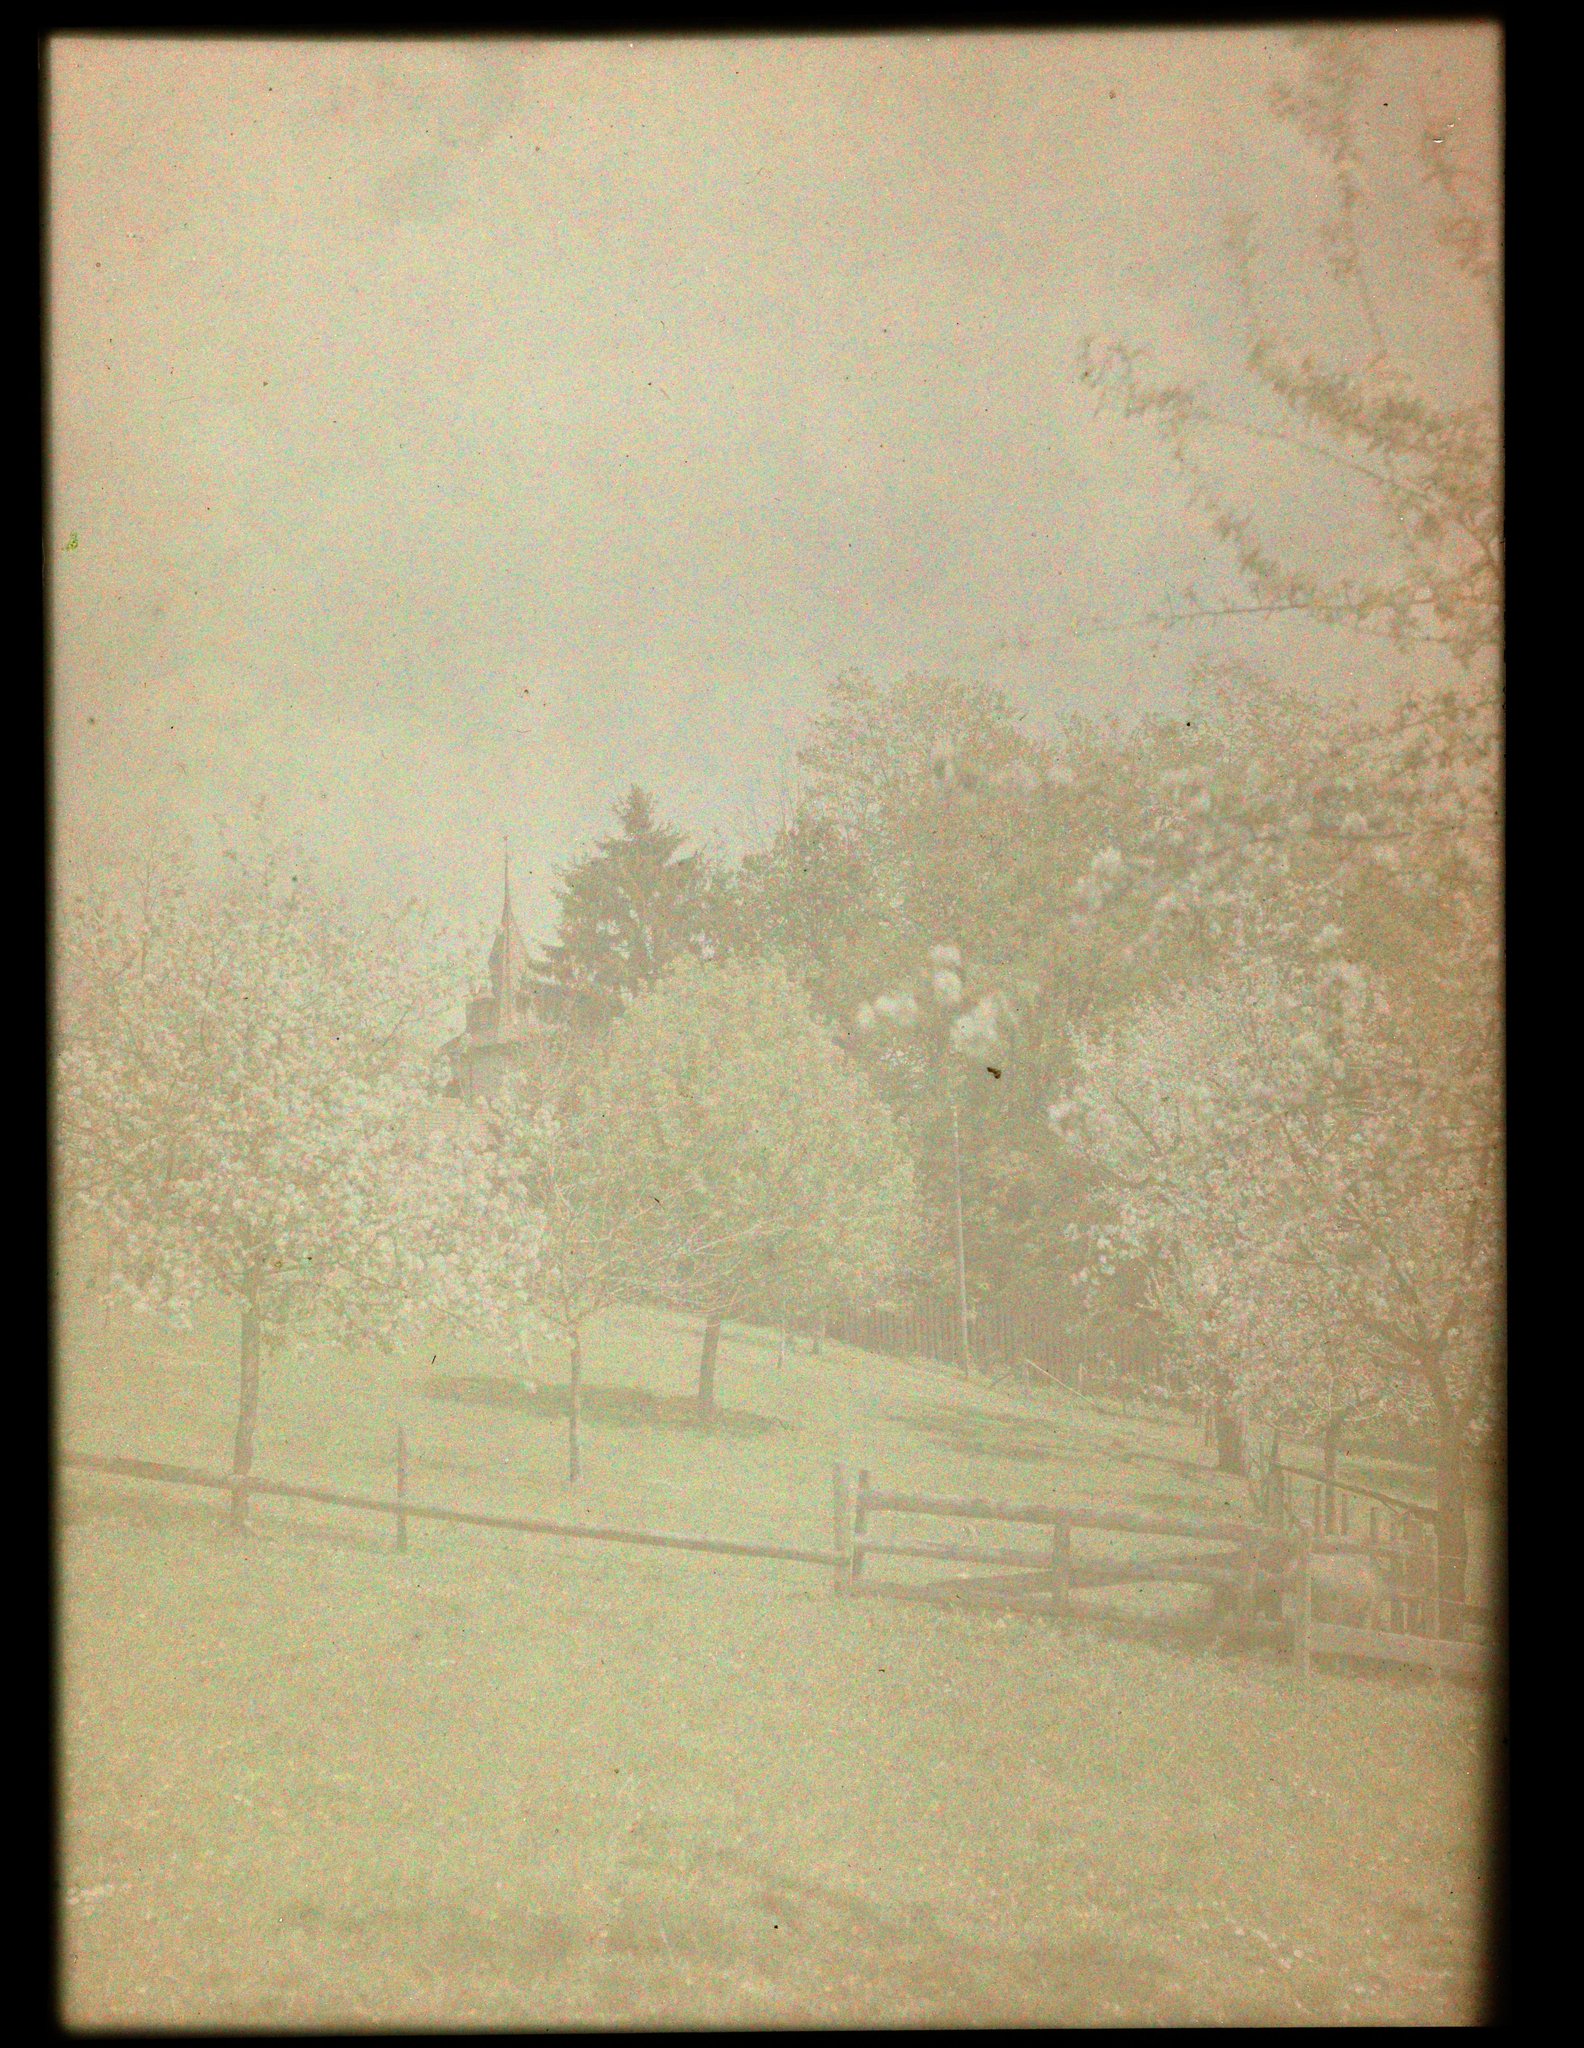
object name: color slide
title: Bloeiende boom in een wei tegen een heuvel, met een kerk op de achtergrond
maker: adolphe burdet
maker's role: fotograaf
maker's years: 1860-1940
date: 1907-1930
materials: glass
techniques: autochrome process, slide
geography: netherlands